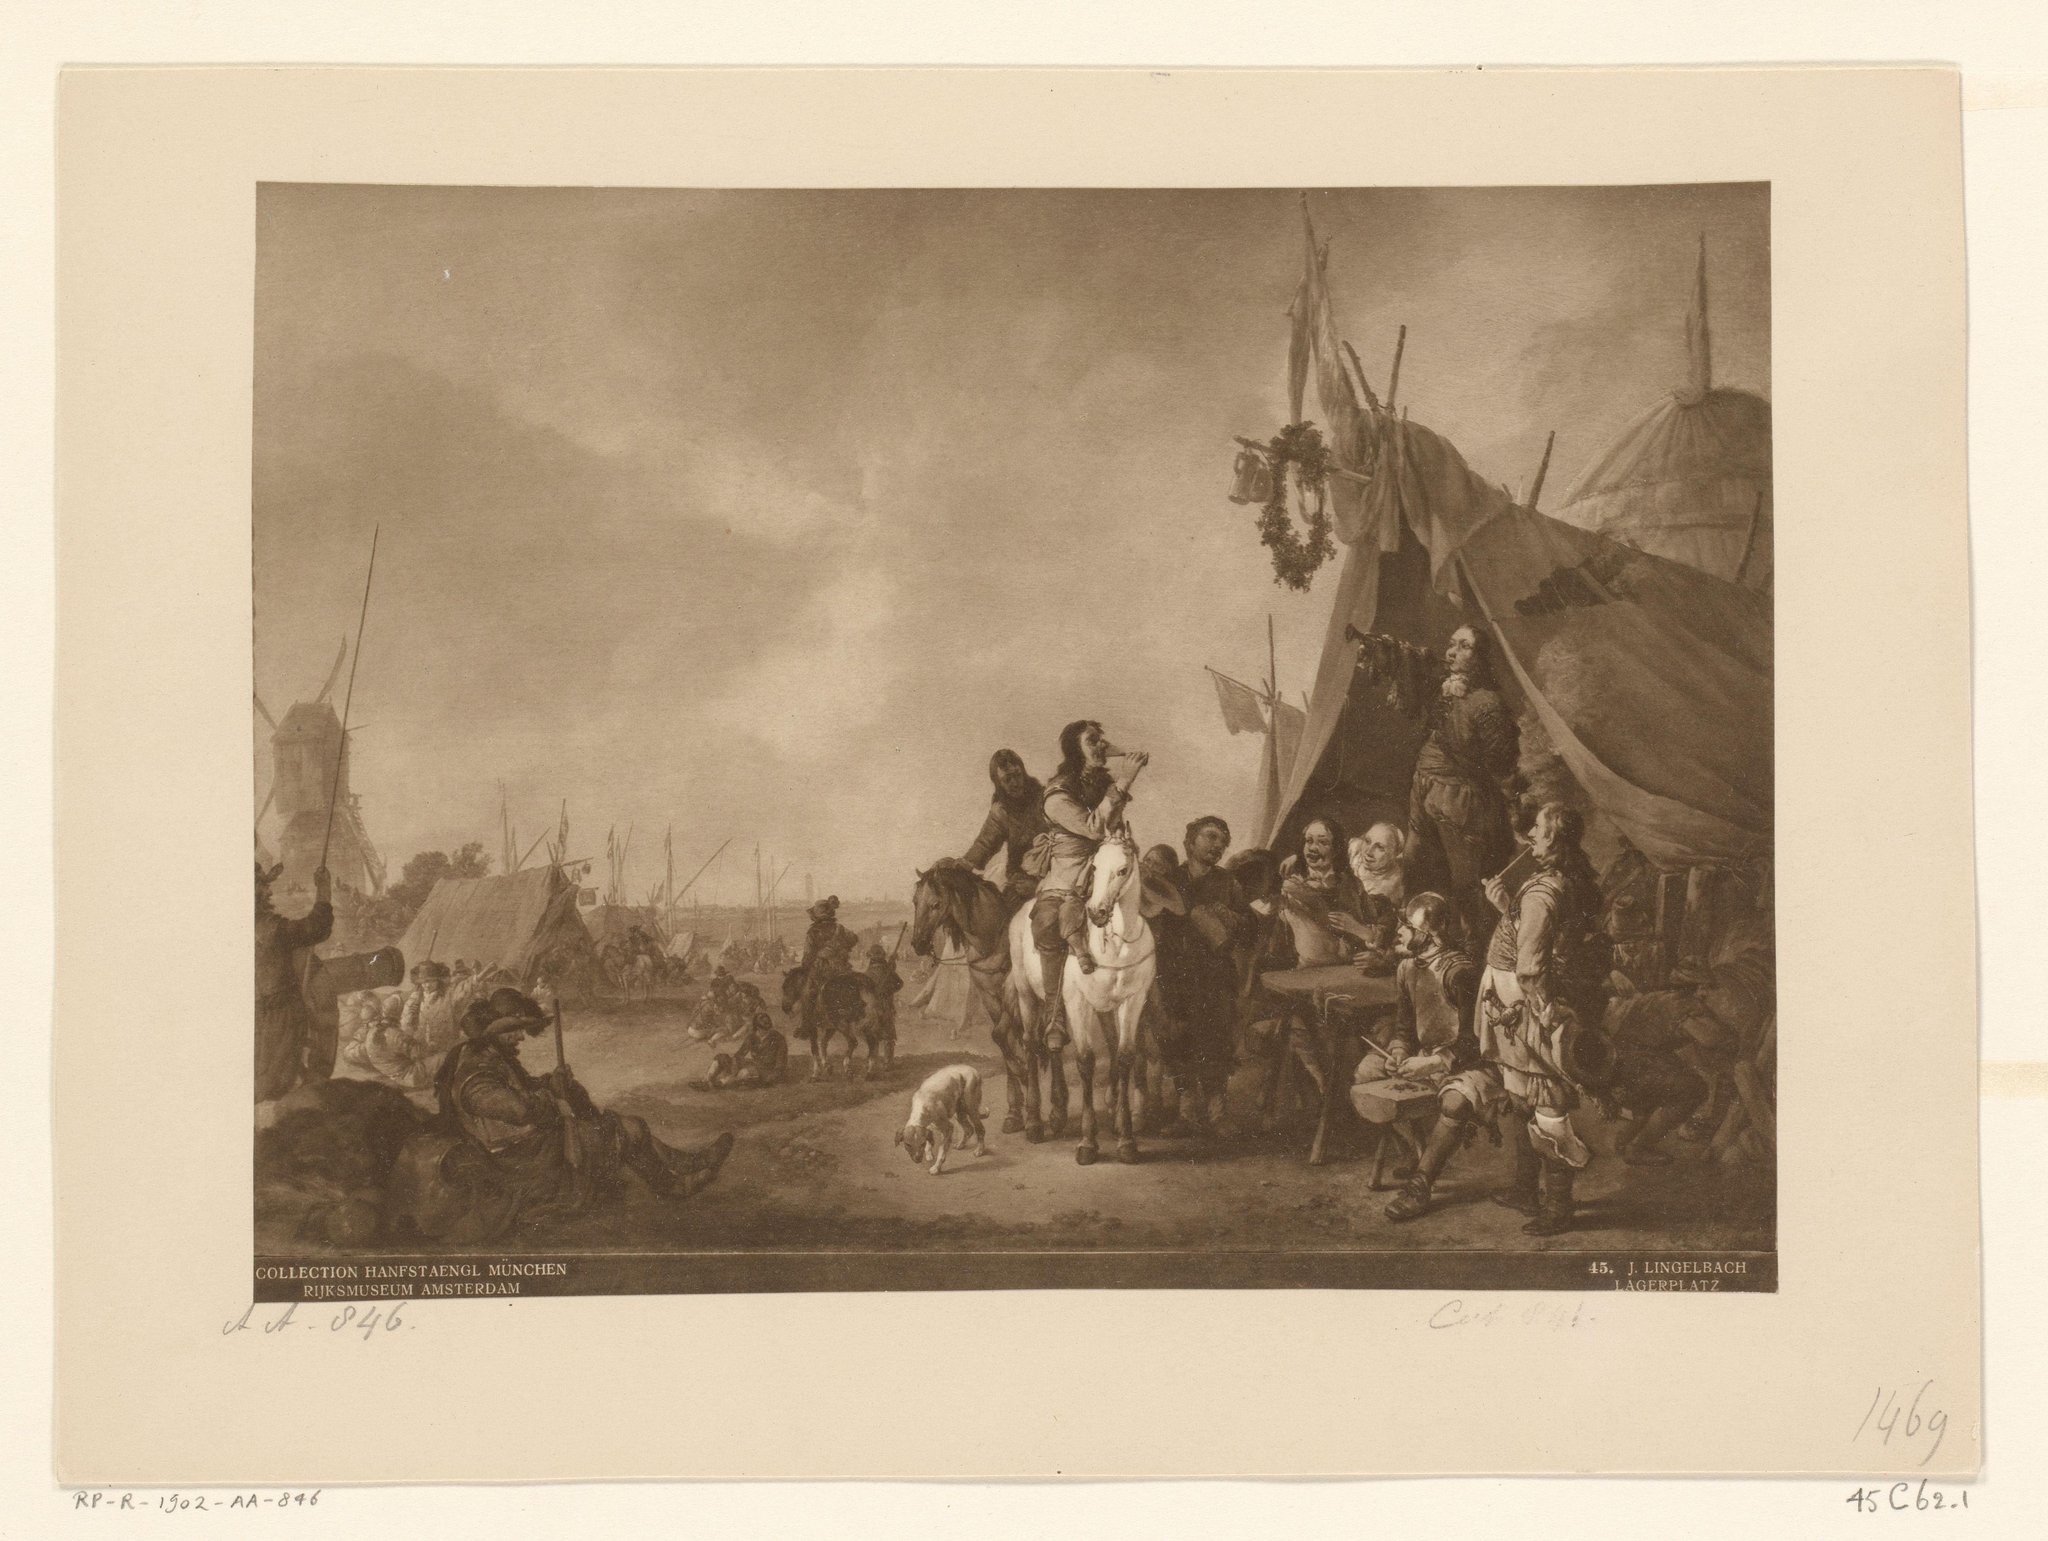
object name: photomechanical print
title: J. Lingelbach Lagerplatz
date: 1902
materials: cardboard, paper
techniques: photograph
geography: munich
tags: (military) camp with tents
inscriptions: stamp: ‘ICON’, inscription: ‘Collection Hanfstaengl München/ Rijksmuseum Amsterdam/ 45. (...)’, number: ‘1469’